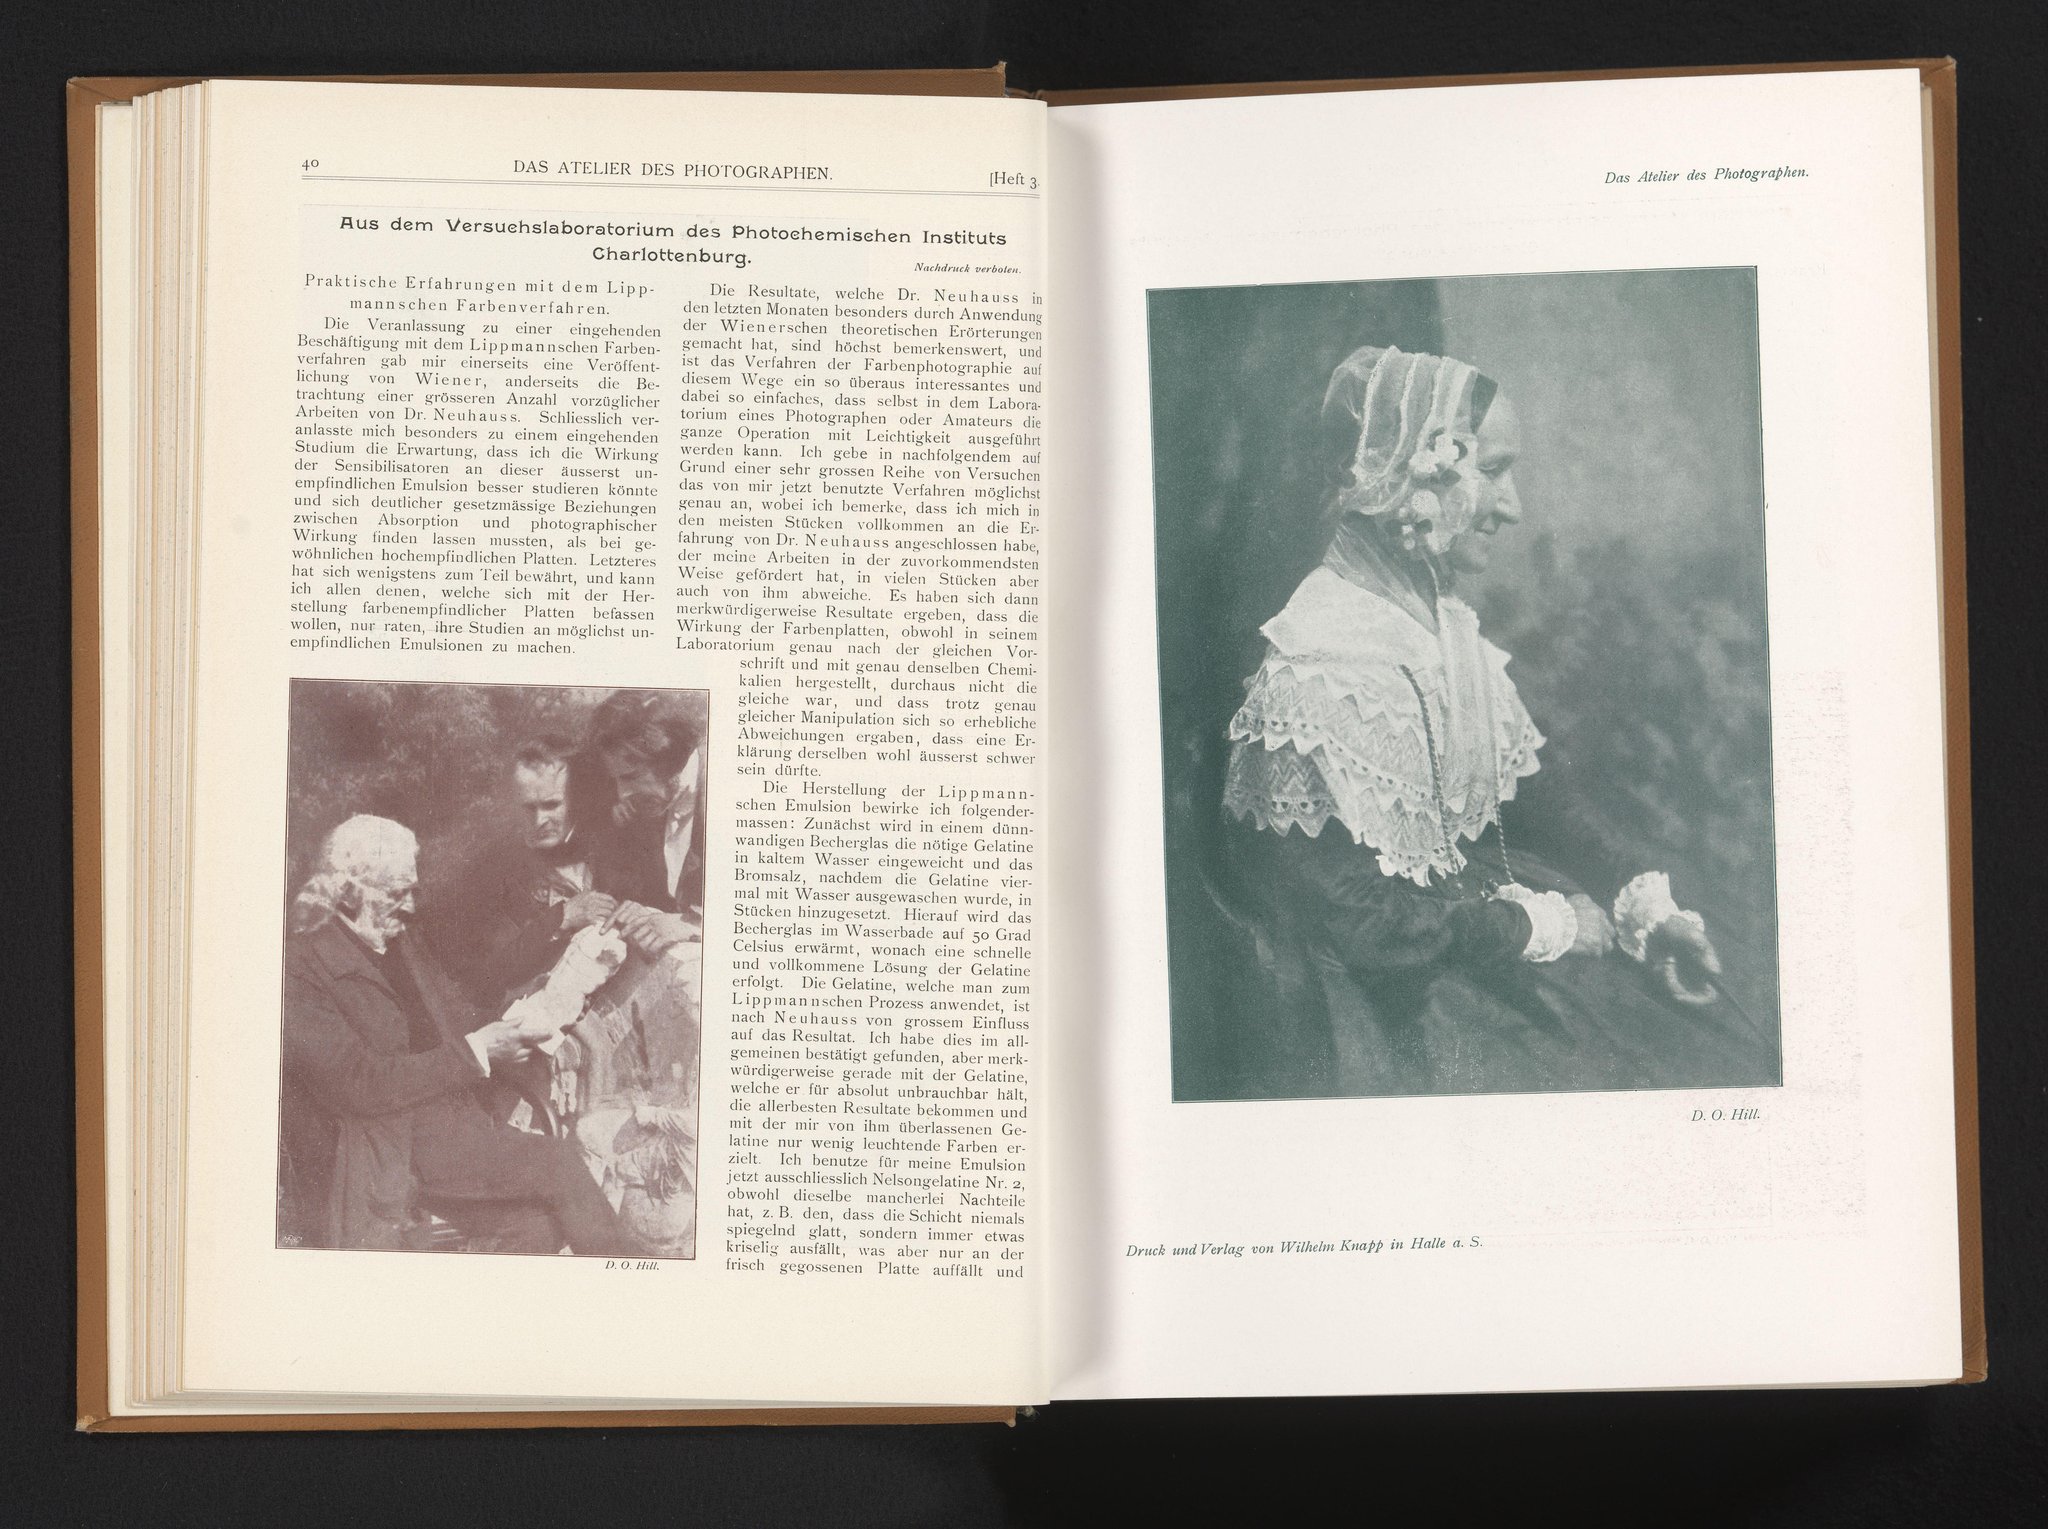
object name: page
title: Portret van een onbekende vrouw in klederdracht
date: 1895-1900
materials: paper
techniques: autotype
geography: halle an der saale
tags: historical persons - bb - woman, folk costume, regional costume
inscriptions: inscription: ‘Das Atelier des Photographen.’